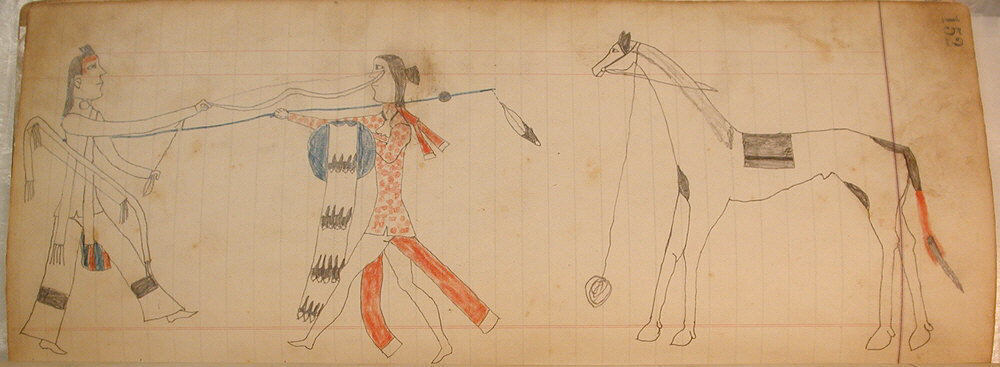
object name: drawing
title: Maffet Ledger: Drawing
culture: cheyenne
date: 1874-1881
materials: crayon, graphite, paper, watercolor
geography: united states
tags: bow and arrow,men,women,horses